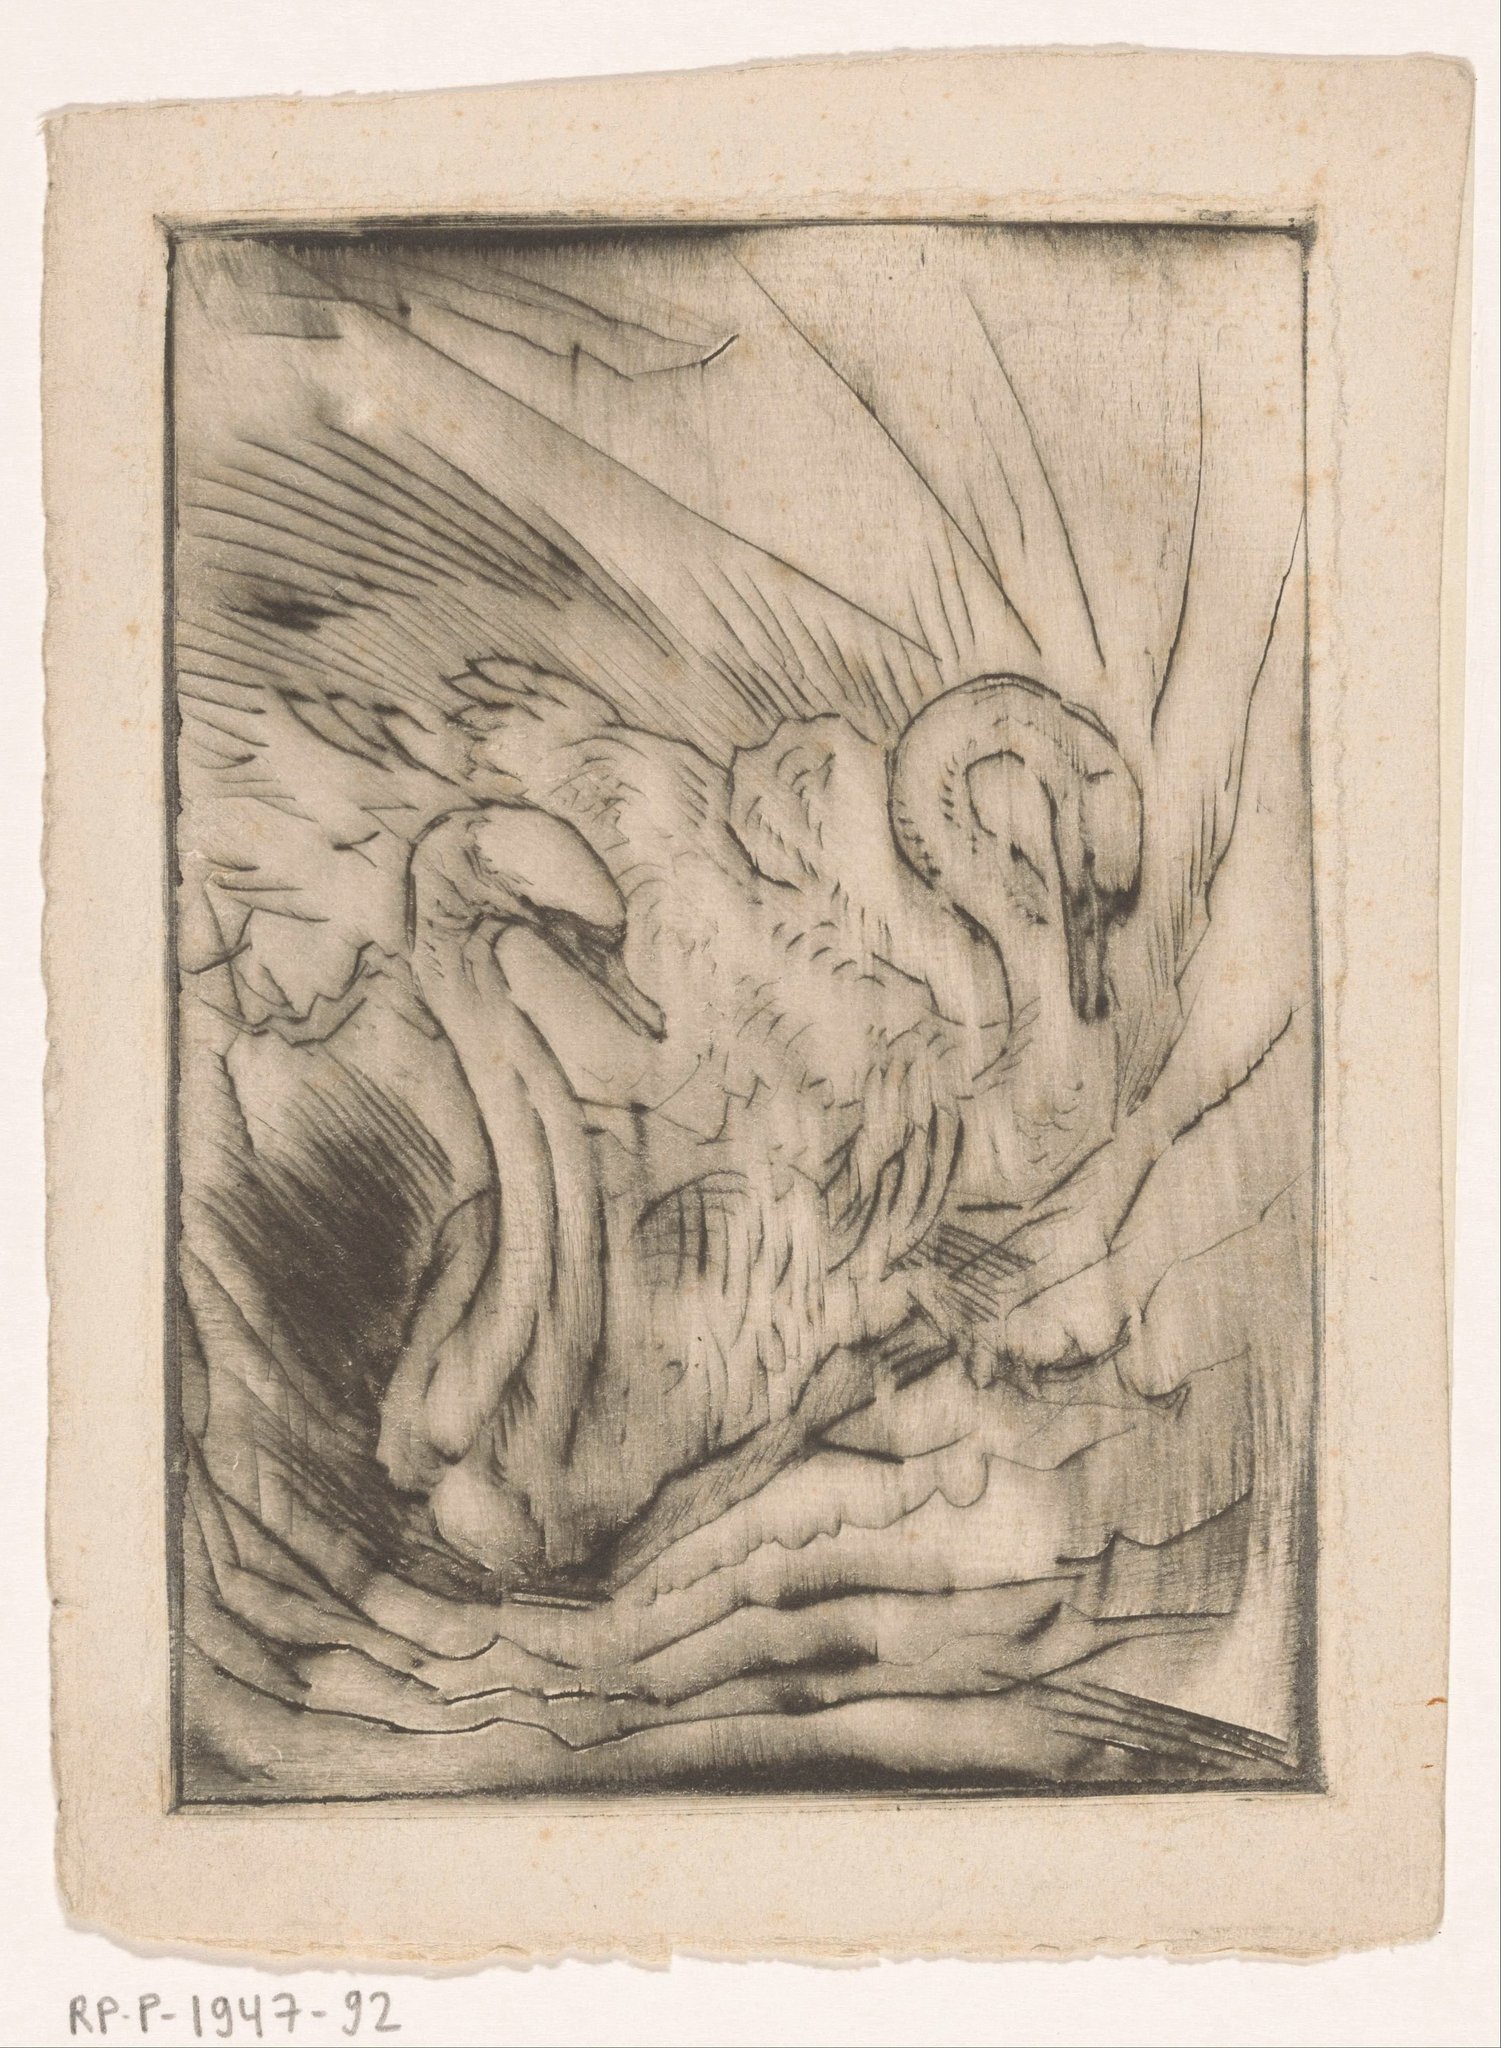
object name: print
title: Twee zwanen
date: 1878-1943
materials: paper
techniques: drypoint, intaglio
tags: water-birds: swan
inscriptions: collector's mark: Lugt 2228